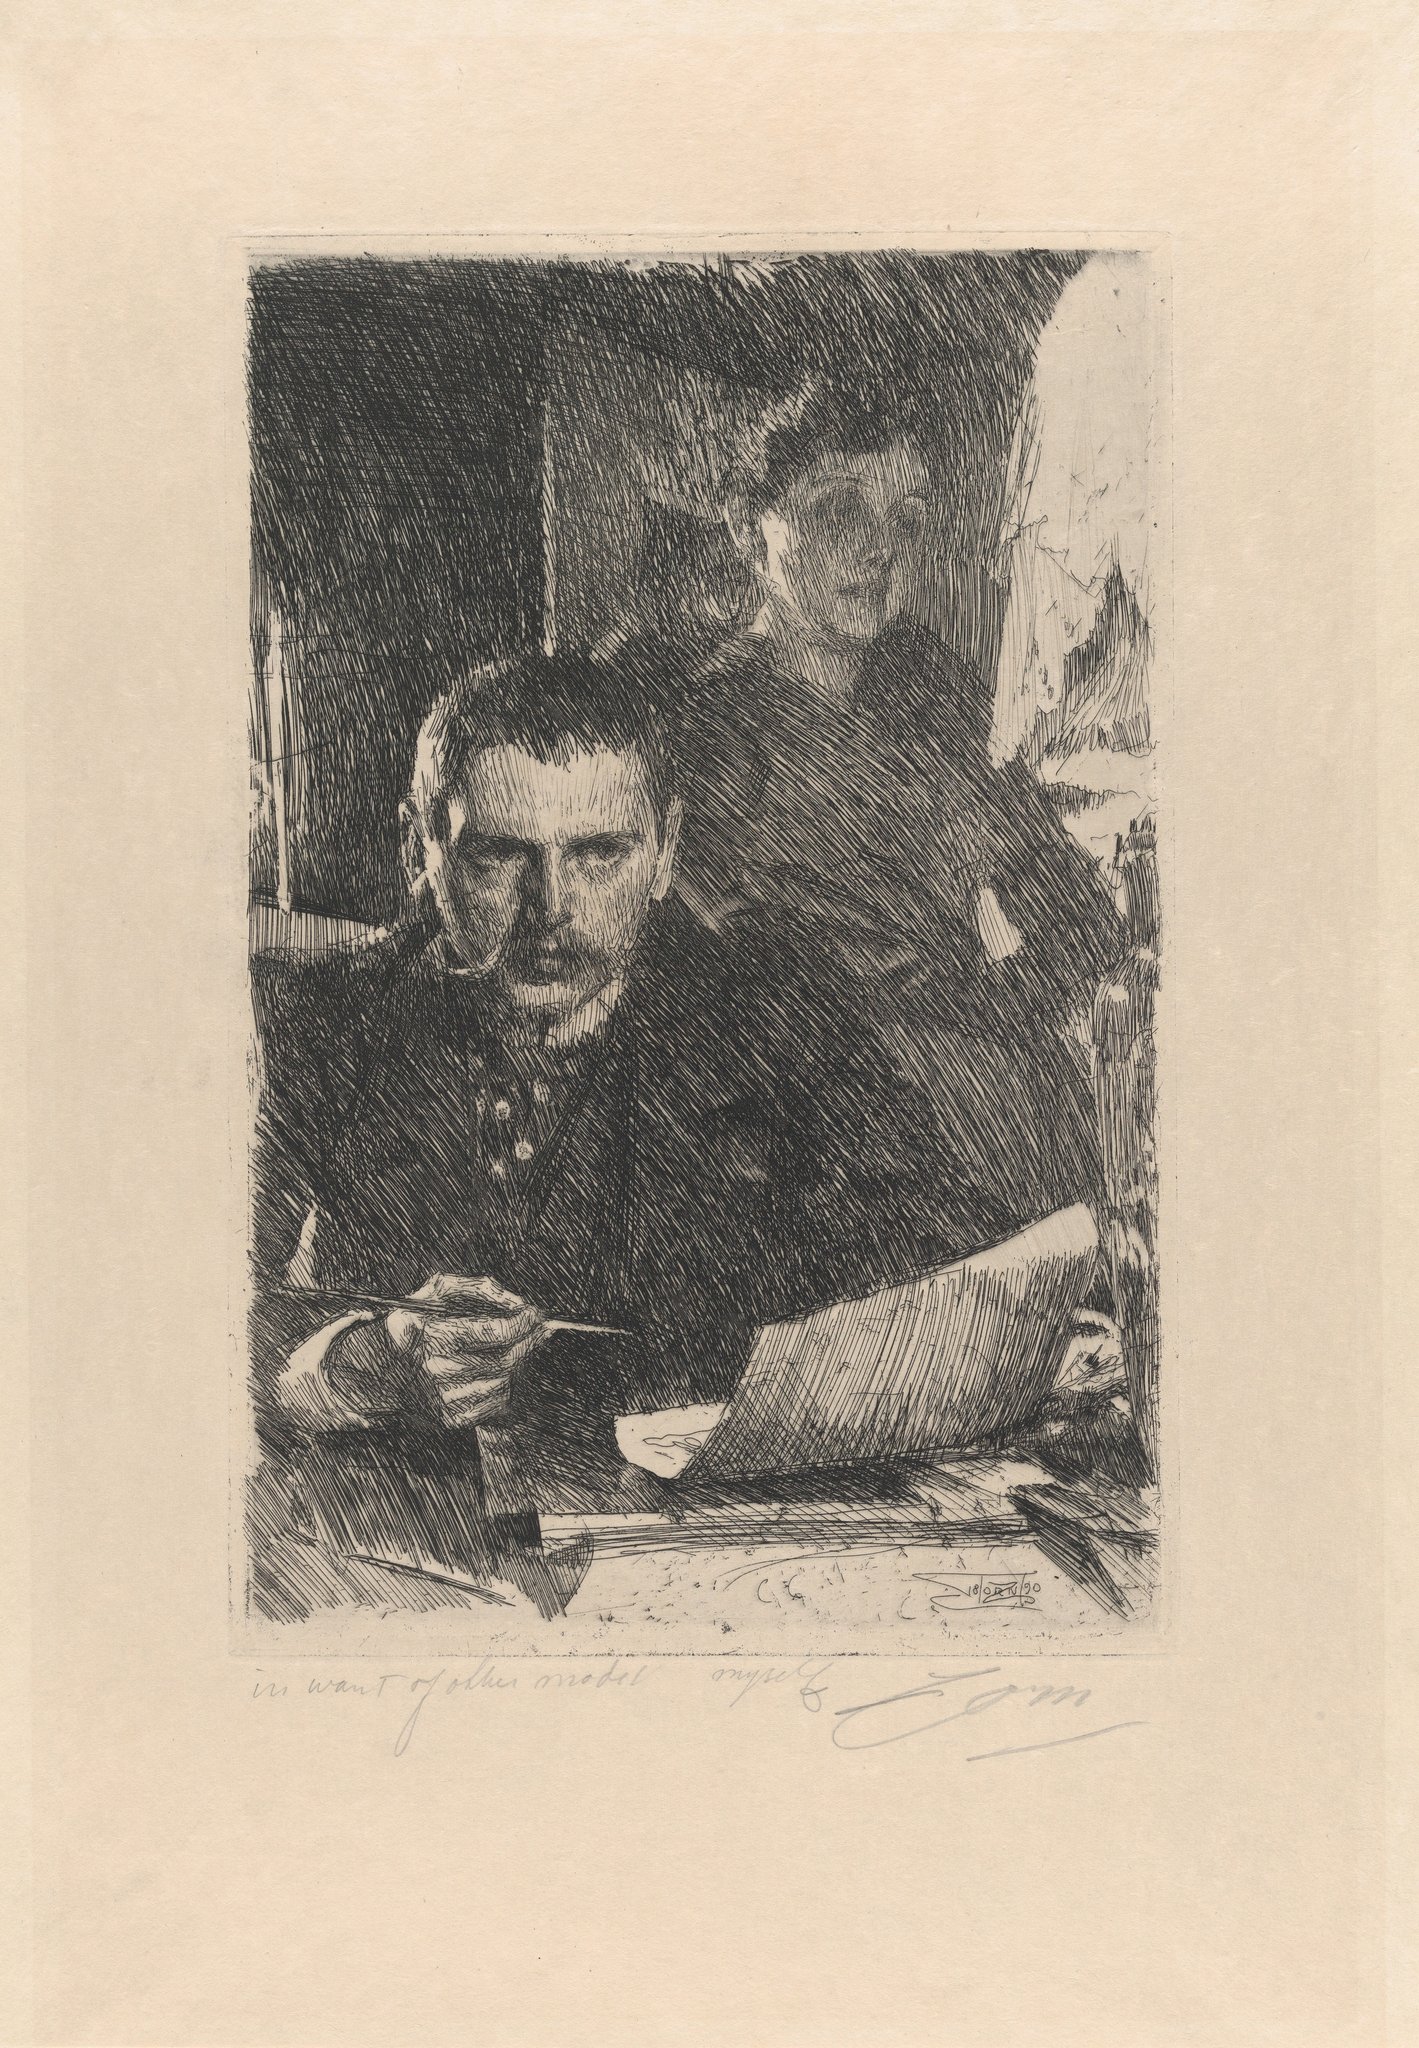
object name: print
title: Zorn and His Wife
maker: anders zorn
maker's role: artist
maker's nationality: swedish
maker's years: 1860-1920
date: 1890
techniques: etching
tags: painting,men,women